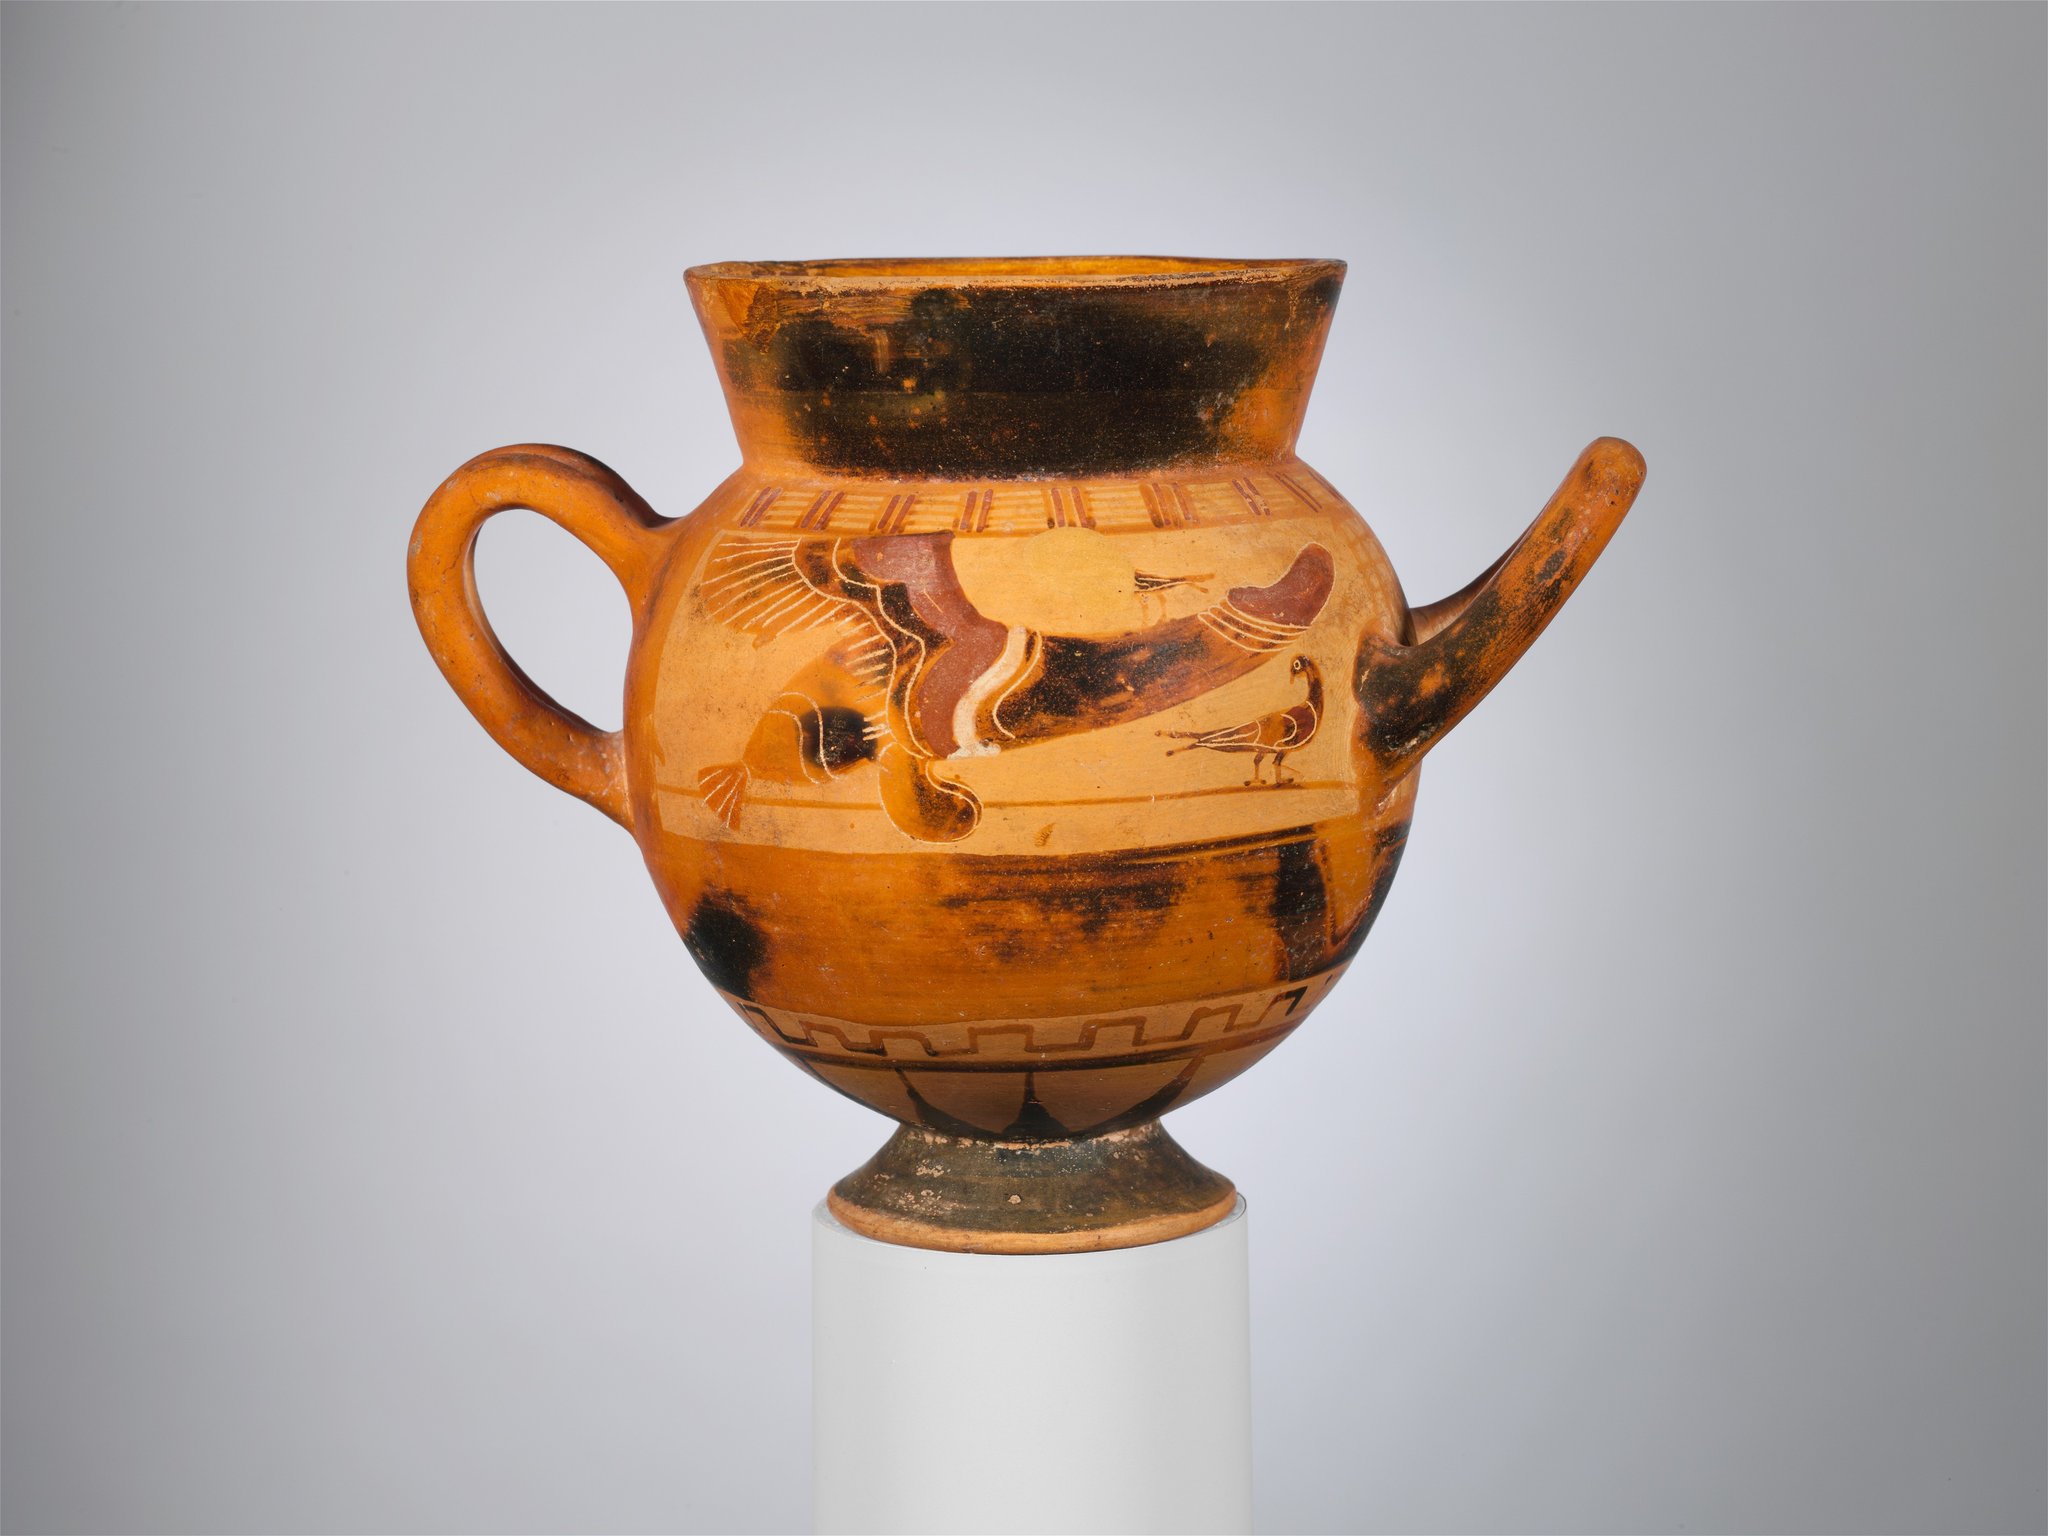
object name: cup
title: Terracotta globular cup with two handles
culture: etruscan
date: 525-501 BCE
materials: terracotta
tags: birds